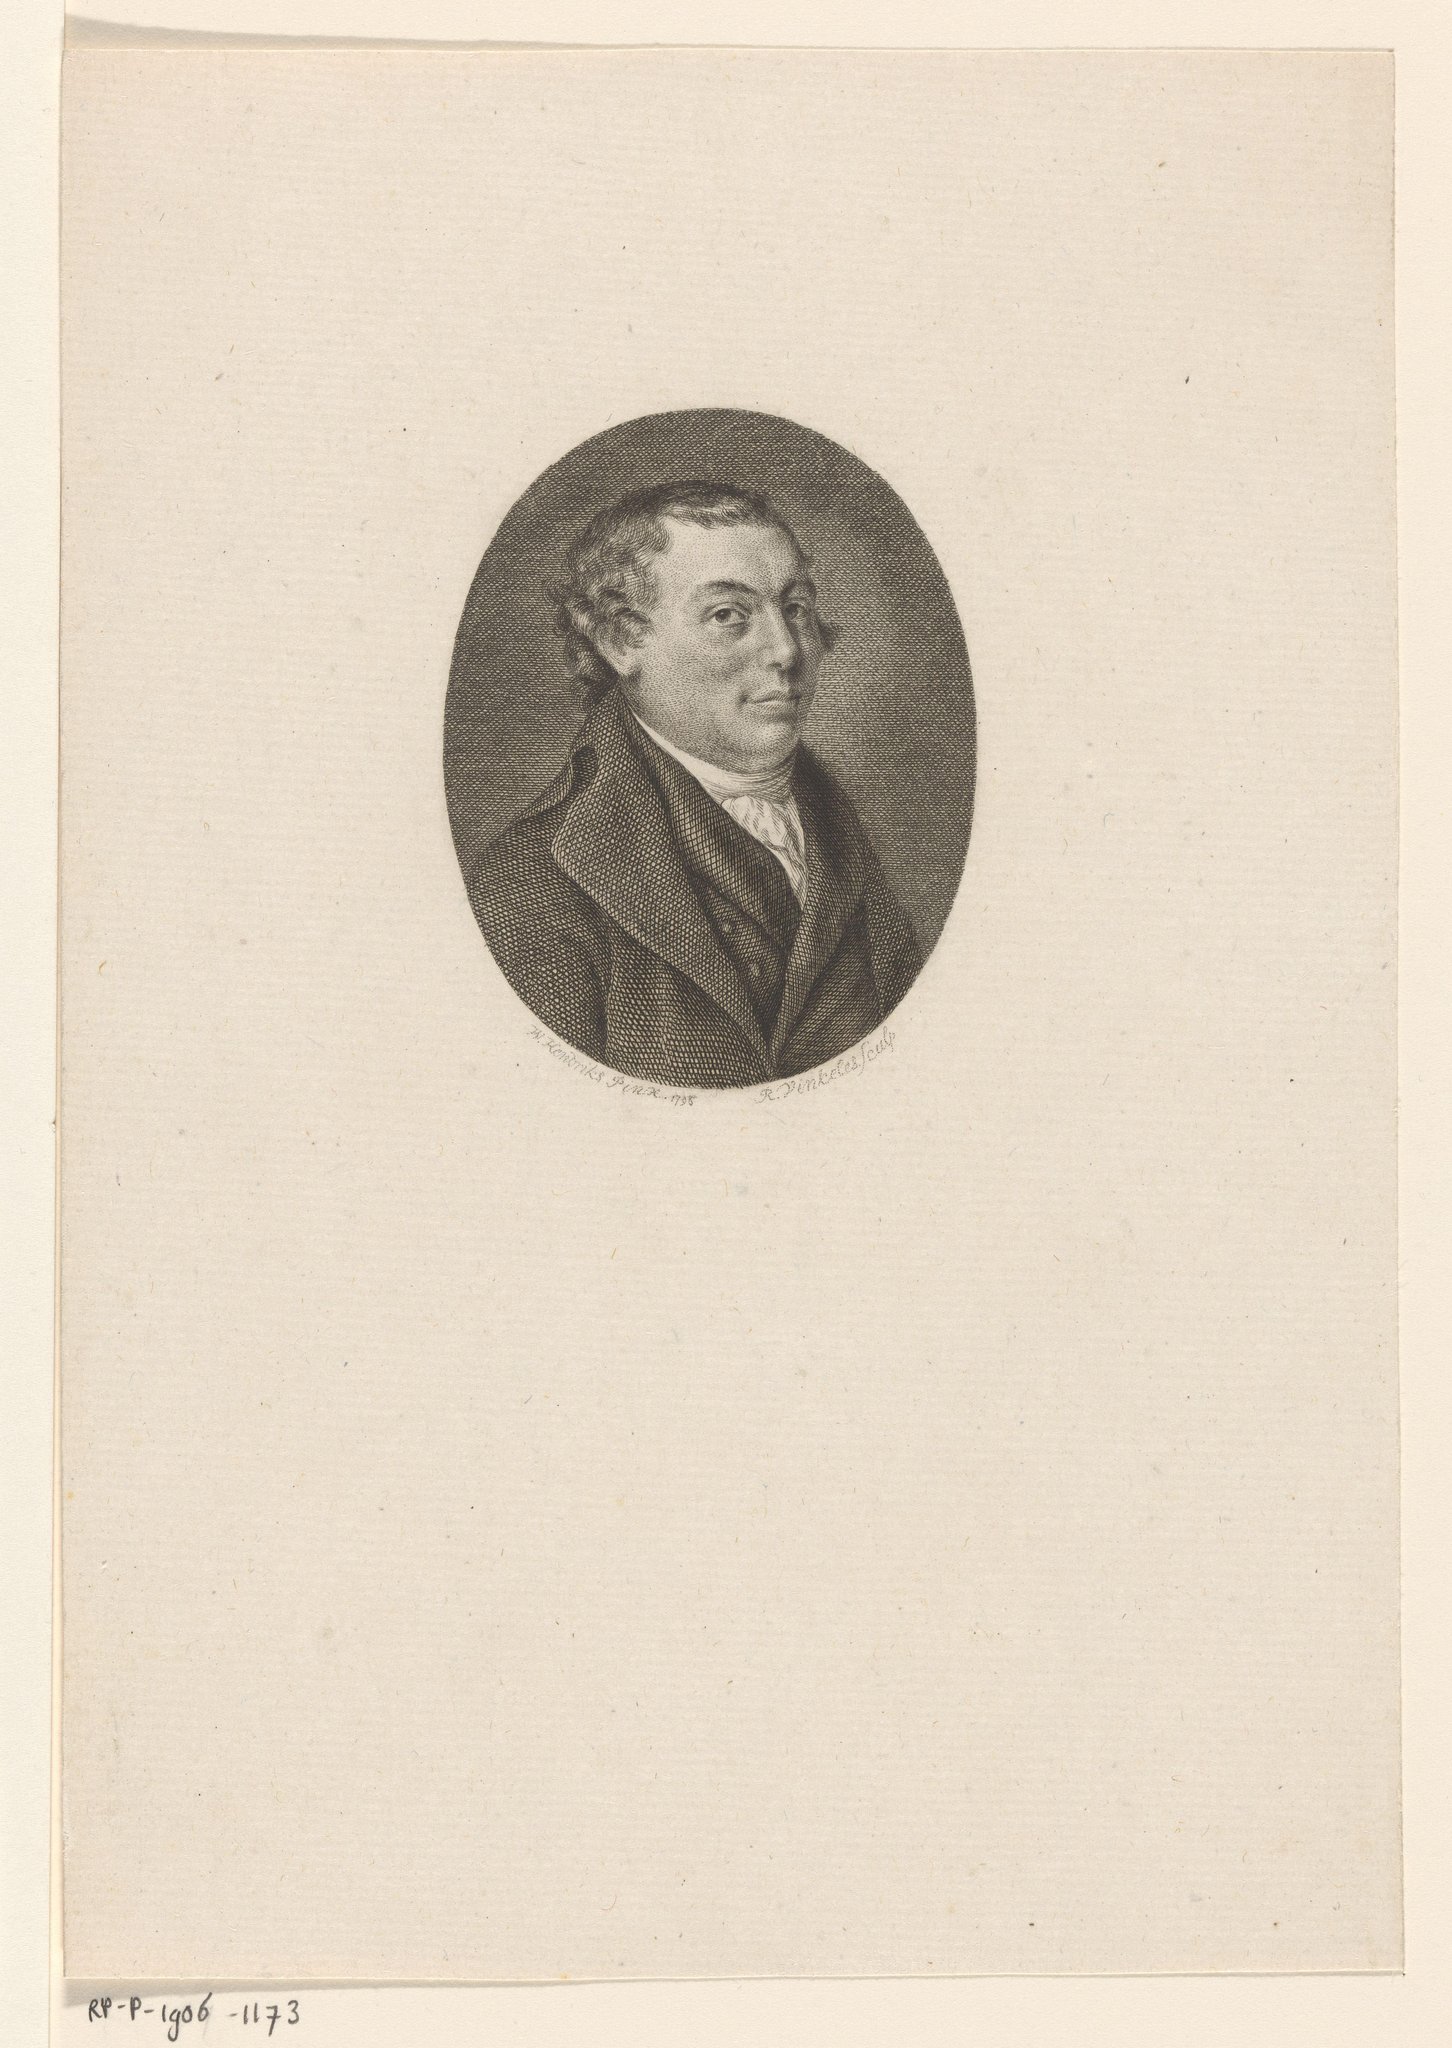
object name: print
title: Portret van Adriaan Pietersz. Loosjes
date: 1796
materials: paper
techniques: engraving, etching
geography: amsterdam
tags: haarlem, bookseller, adriaan pietersz. loosjes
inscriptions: collector's mark: Lugt 2228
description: Latere staat prent ook gebruikt als boekillustratie in: Wagenaar, Jan. Vaderlandsche historie, (...) ten vervolge van Wagenaars Vaderlandsche historie. Dl. 1-43. Amsterdam: Johannes Allart, 1786-1809.